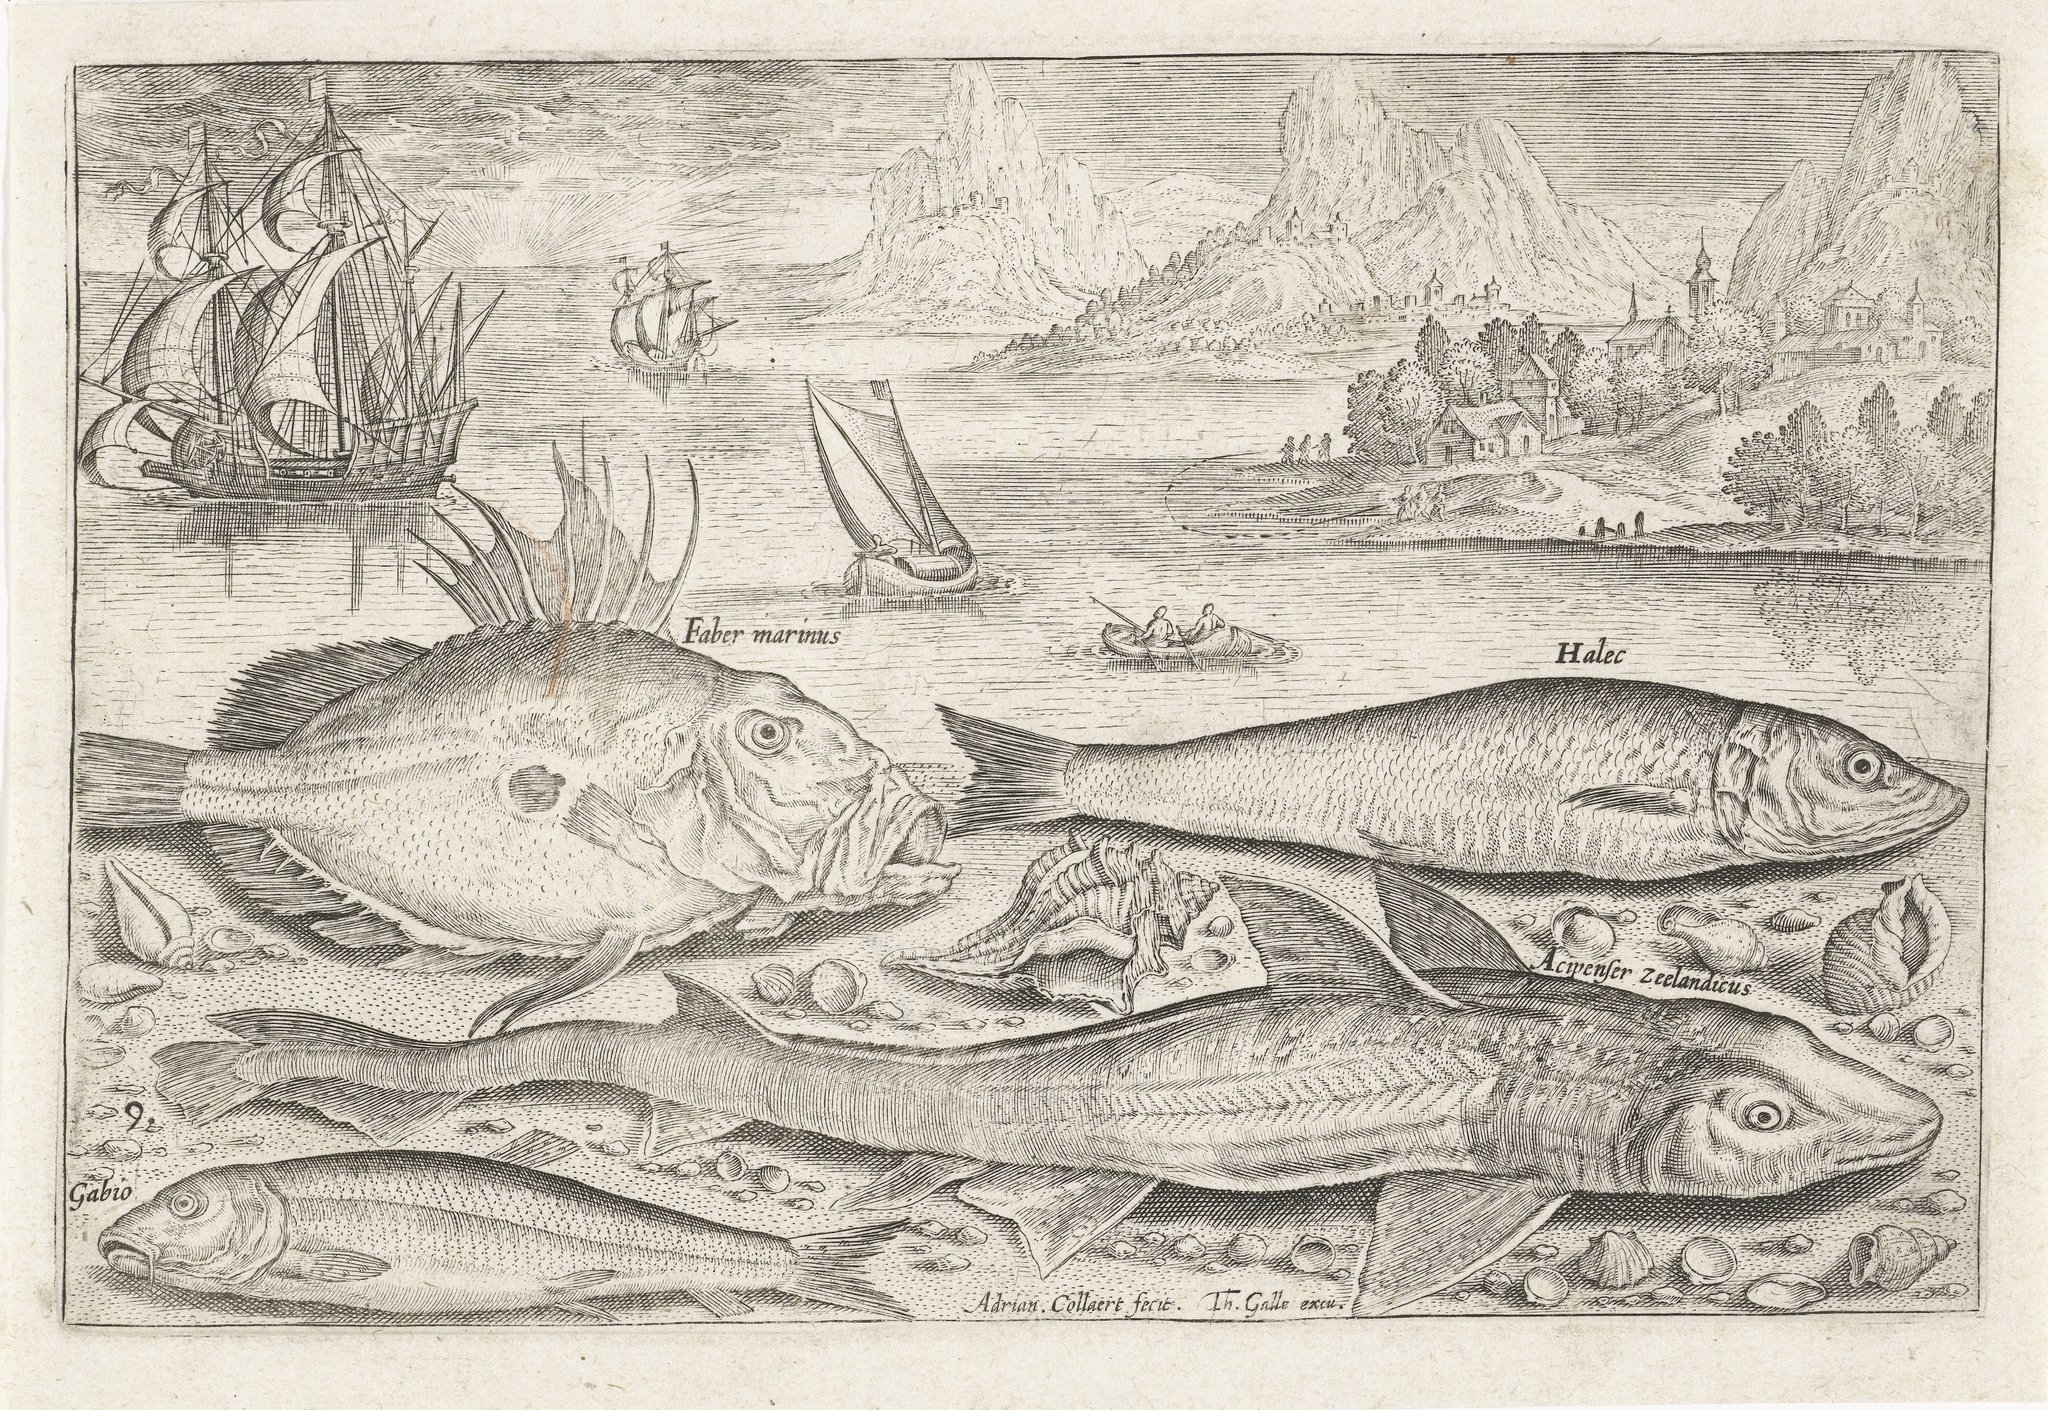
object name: print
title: Vissen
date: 1627-1636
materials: paper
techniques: engraving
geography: antwerp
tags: bony fishes: herring, bony fishes: angelfish, sea (seascape), bony fishes: sturgeon, bony fishes: goby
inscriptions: collector's mark: Lugt 2228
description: Een grondel, een braam, een steur en een haring liggen samen met wat schelpen aangespoeld op het strand. Op de achtergrond de zee met enkele schepen. De prent maakt deel uit van een serie met vissen als onderwerp.